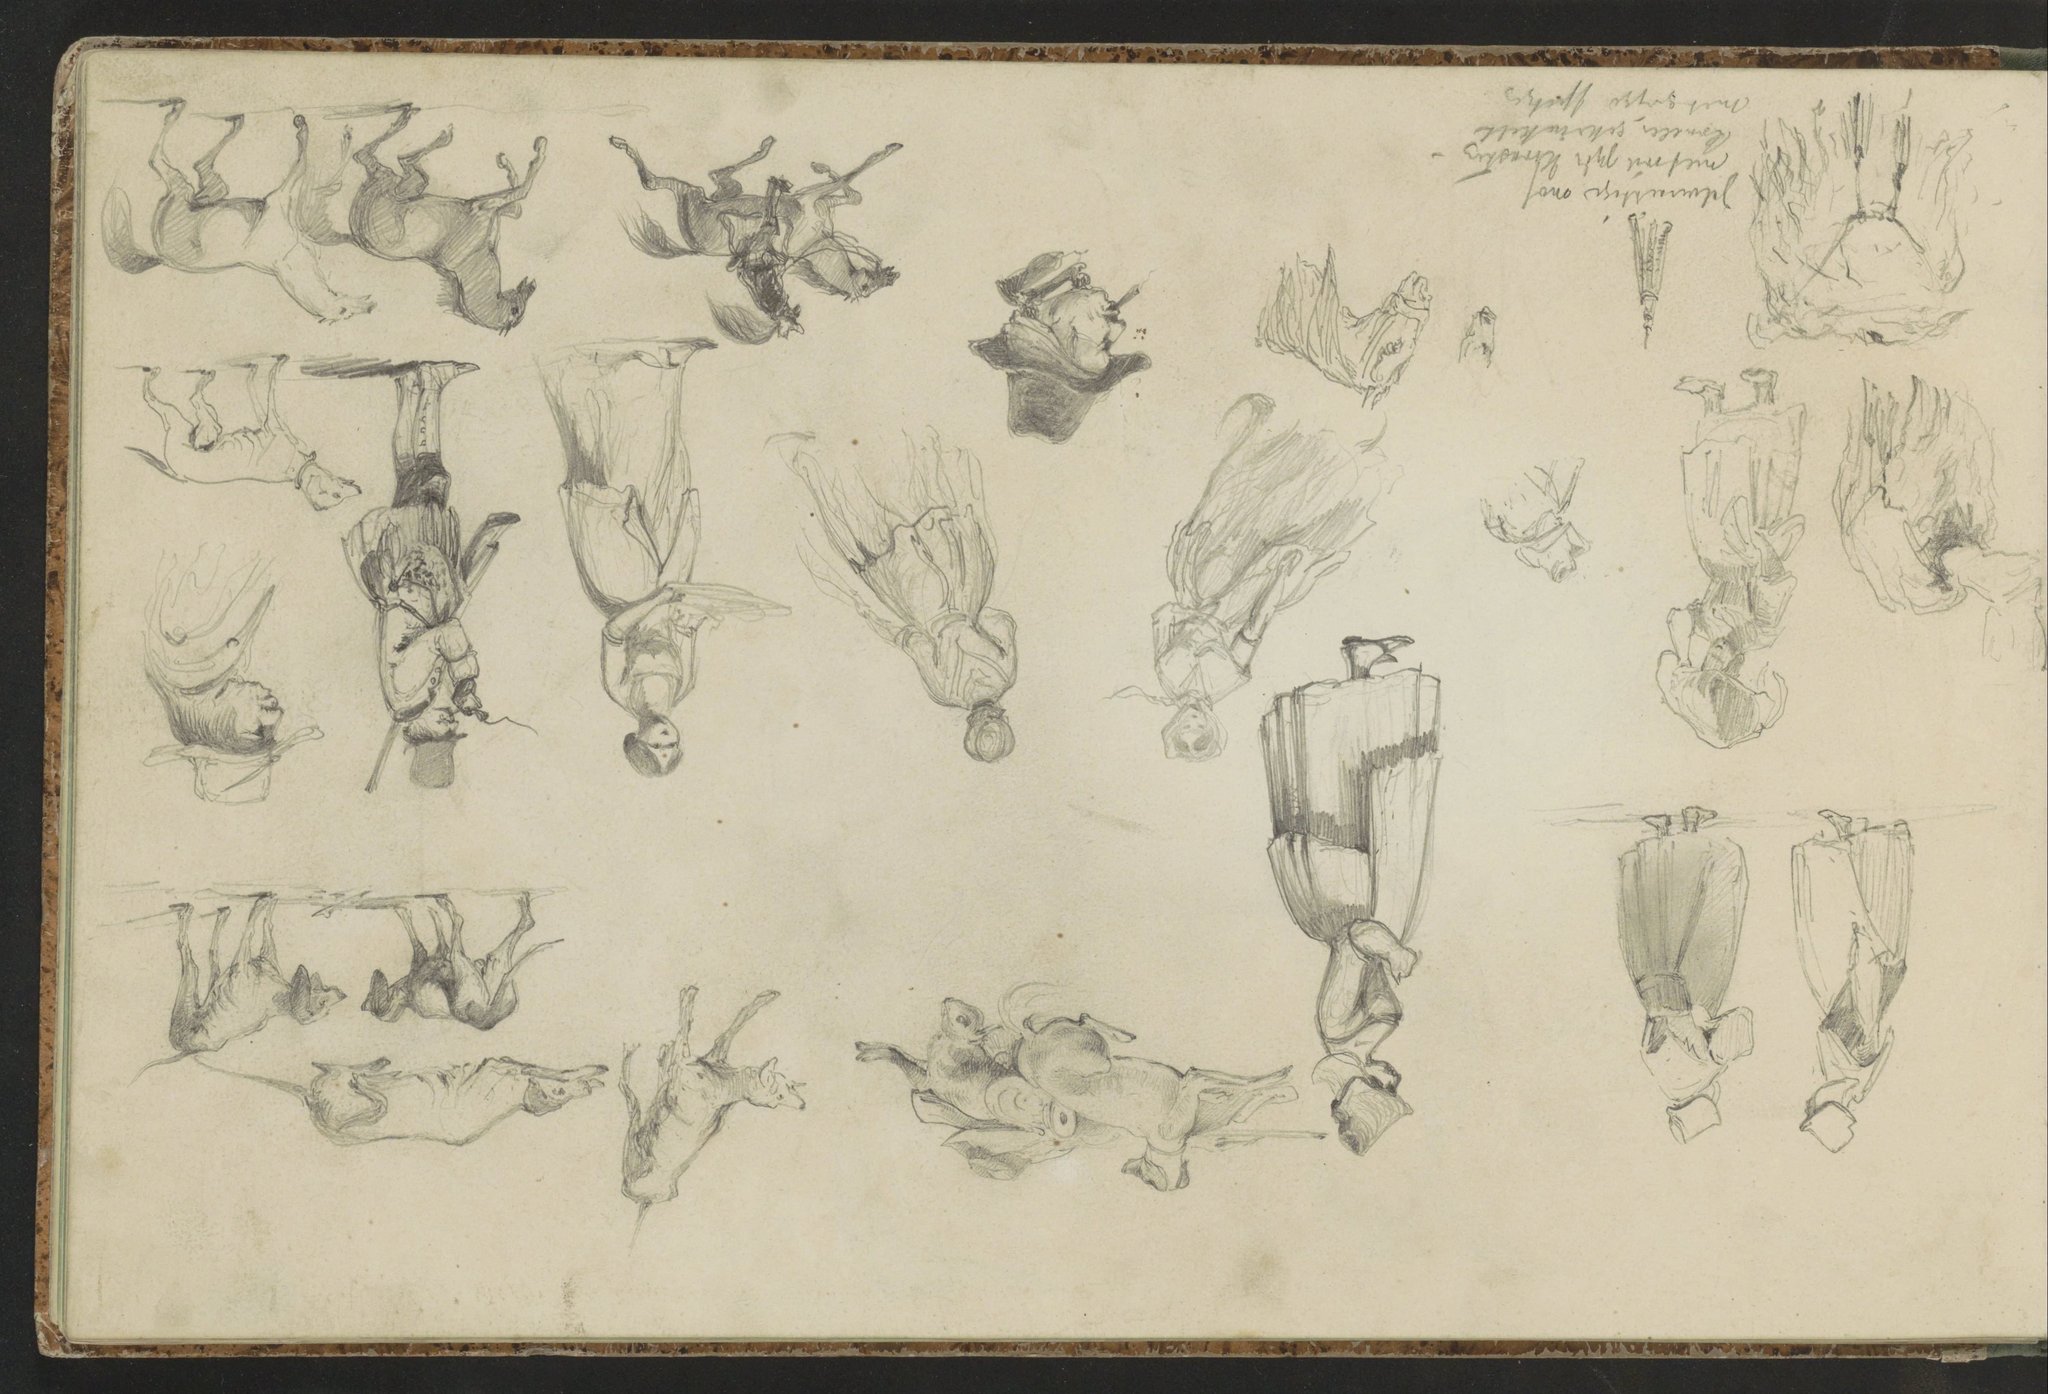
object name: sketchbook leaf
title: Vrouwen- en mannenfiguren, honden, paarden en een ruiter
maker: johannes tavenraat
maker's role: draughtsman, painter, print maker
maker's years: 1809-1881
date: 1840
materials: paper, pencil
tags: riding a horse, ass, or mule; rider, horseman, adult woman, adult man, horse, dog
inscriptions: kleurnotitie, handgeschreven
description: Blad 25 verso uit een schetsboek met 33 bladen.